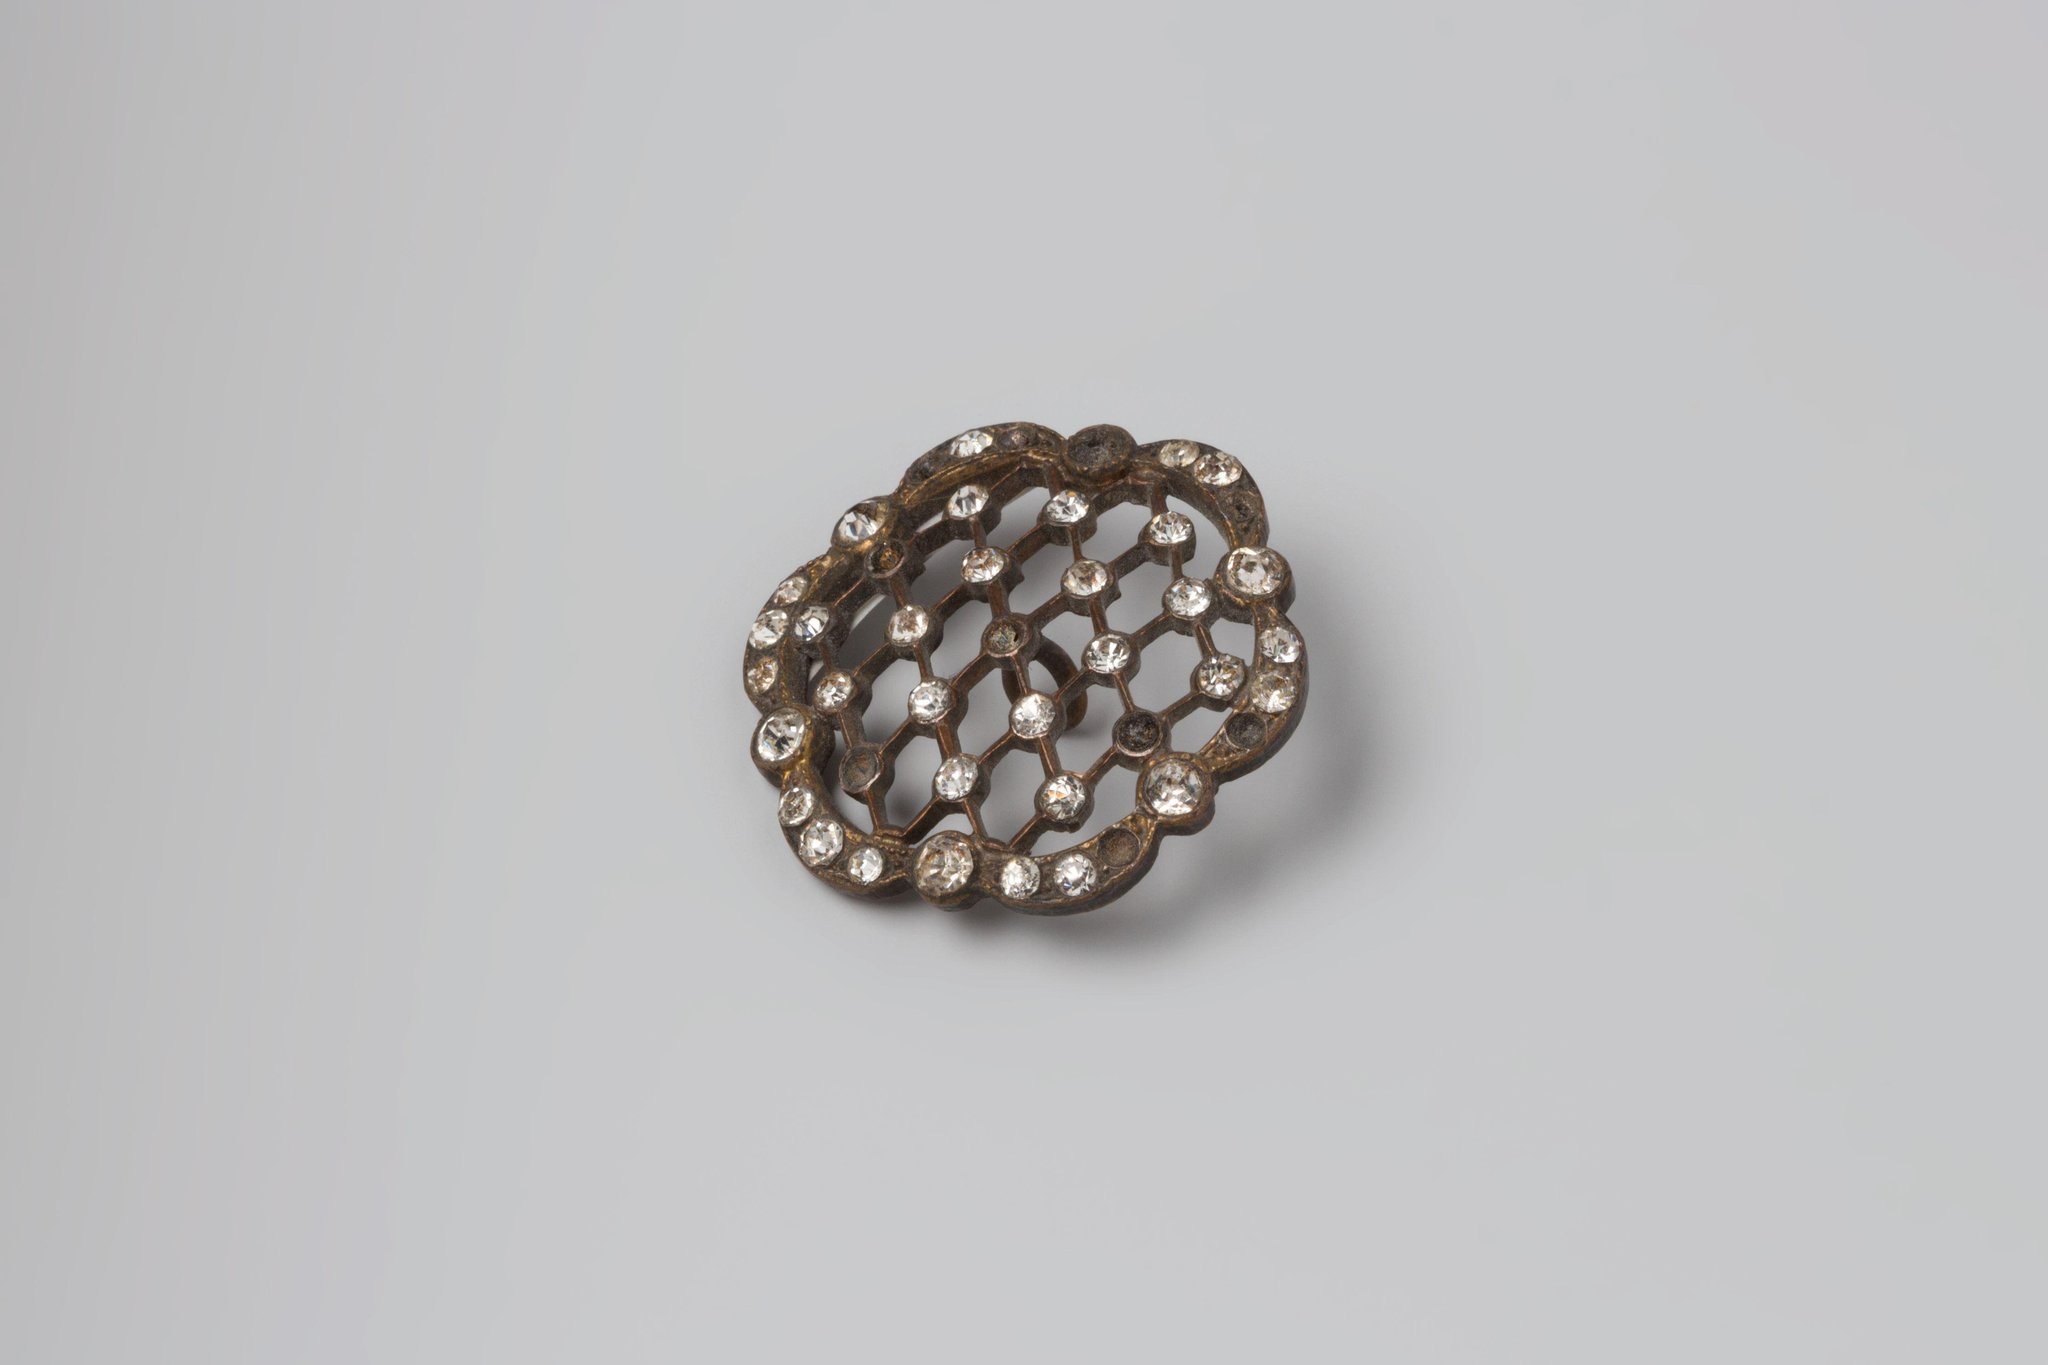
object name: button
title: Knoop van koper met stras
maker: Anonymous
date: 1910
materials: copper, paste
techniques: forging, grinding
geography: france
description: Knoop van koper met stras. Binnen een zesklobbige rand is een ajour rasterwerkvulling gevat, met op de kruispunten telkens een stras, als briljant geslepen.